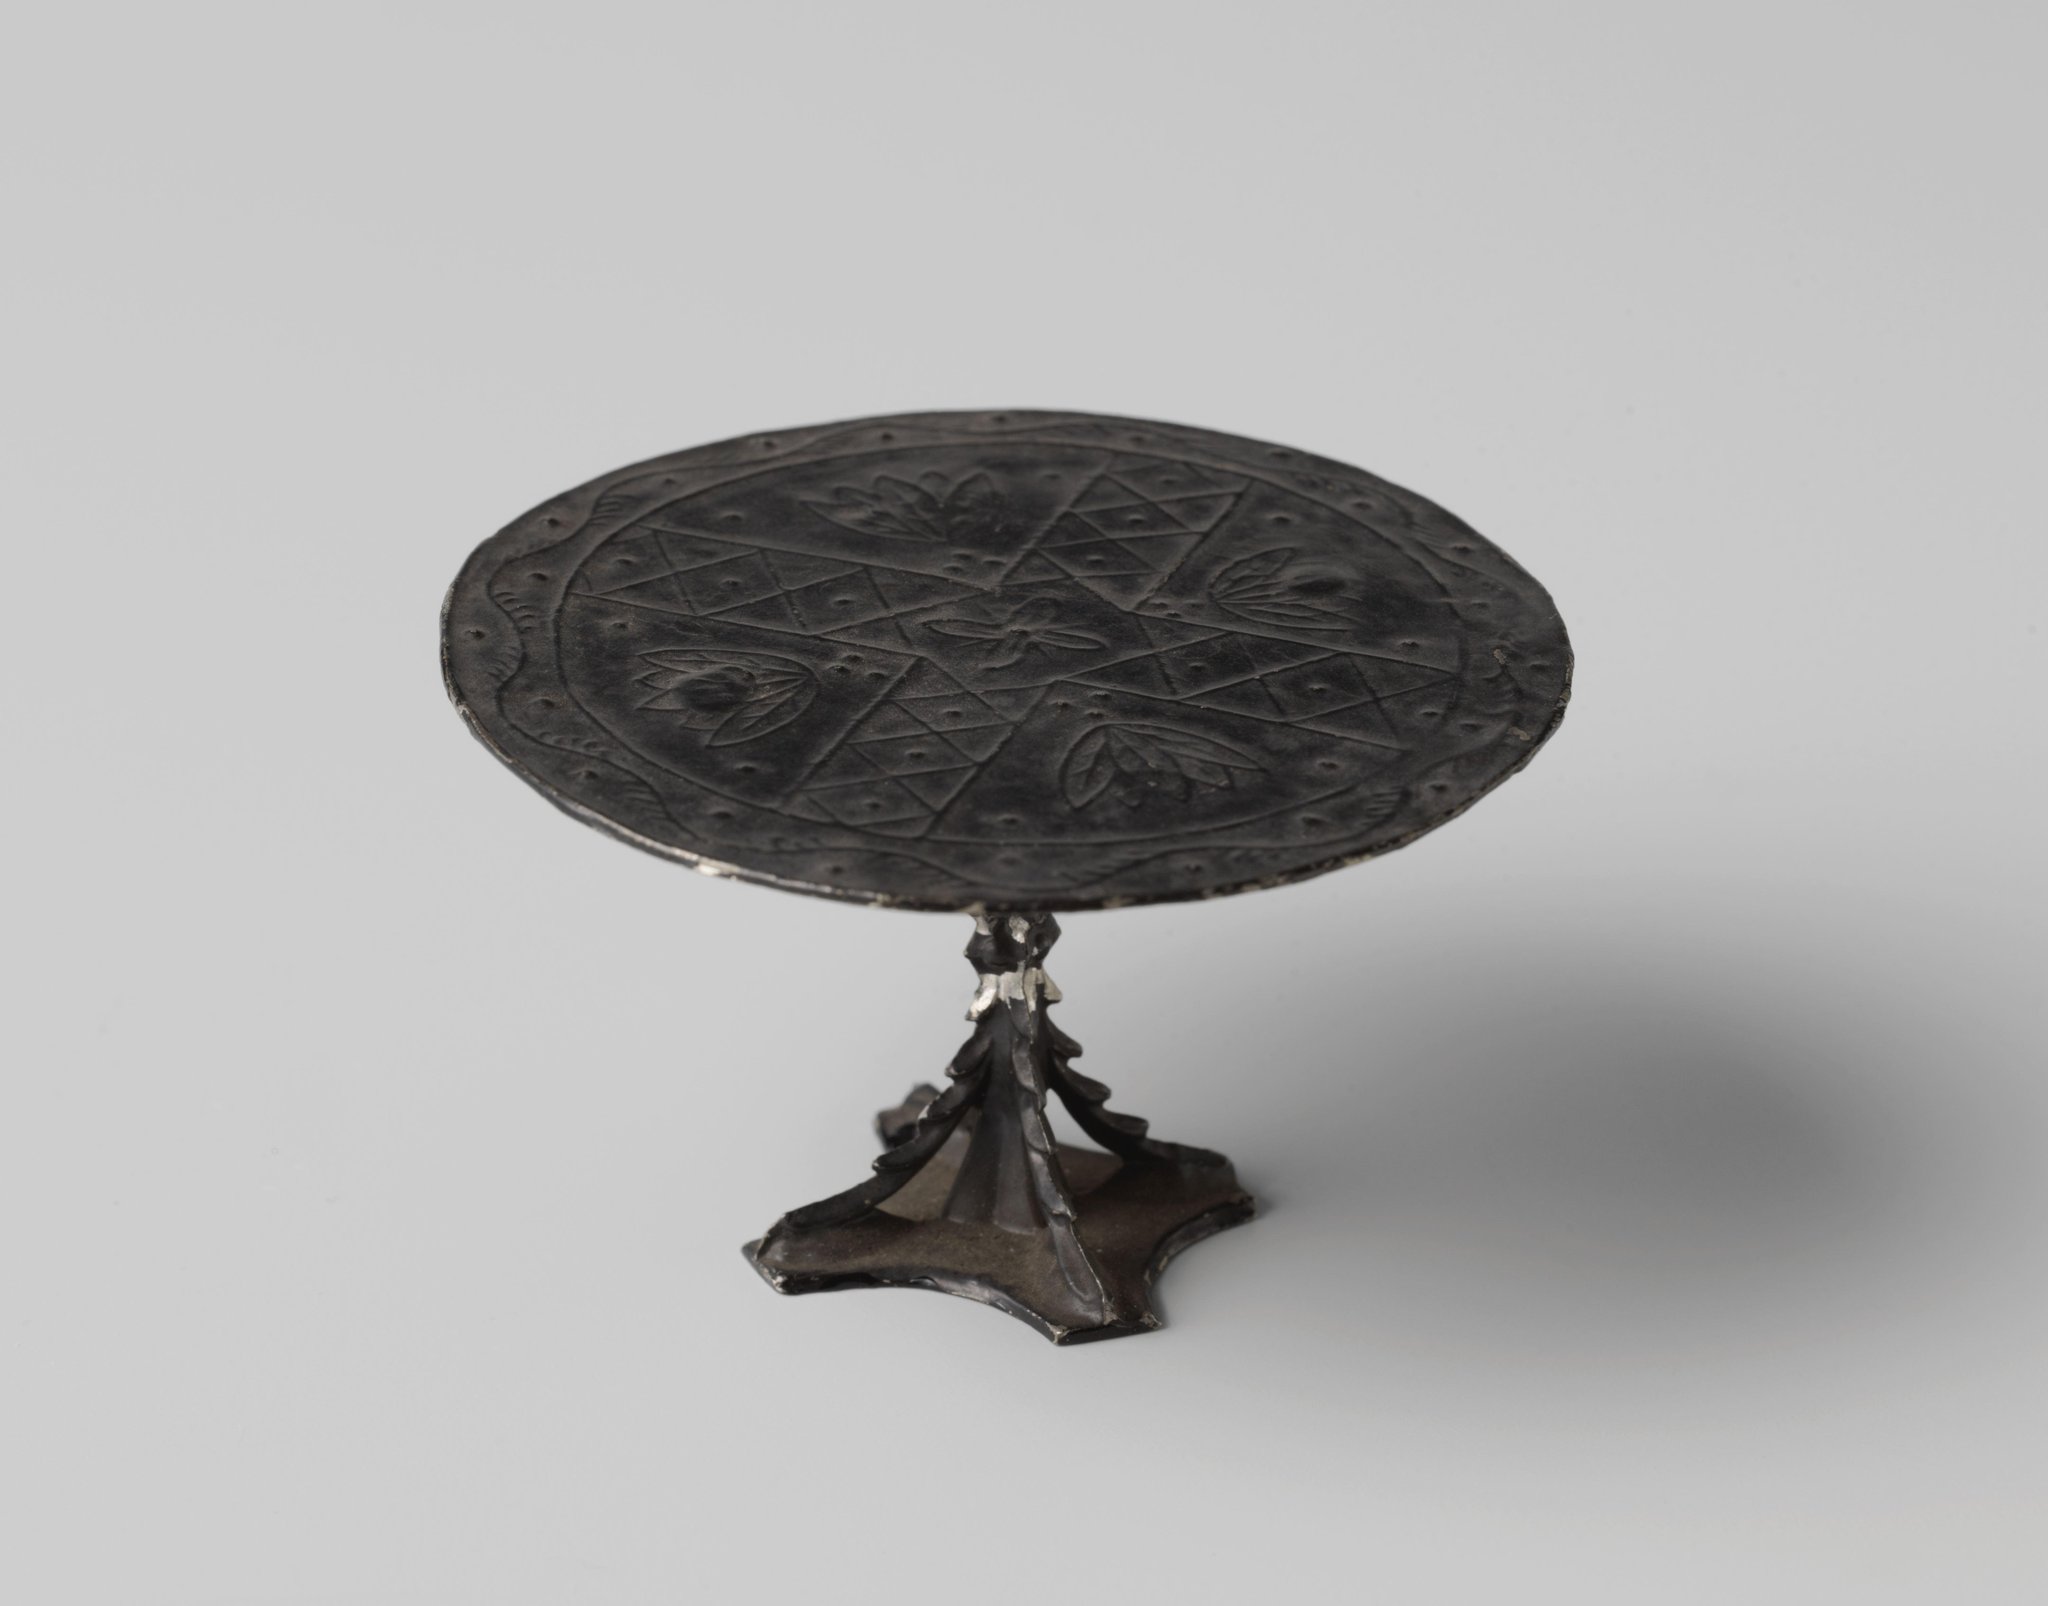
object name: table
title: Tafel met rond blad, met vier bloemen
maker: Anonymous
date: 1800-1849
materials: iron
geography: amsterdam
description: Tafel met rond blad, met vier bloemen in elke kwart van het tafelblad.